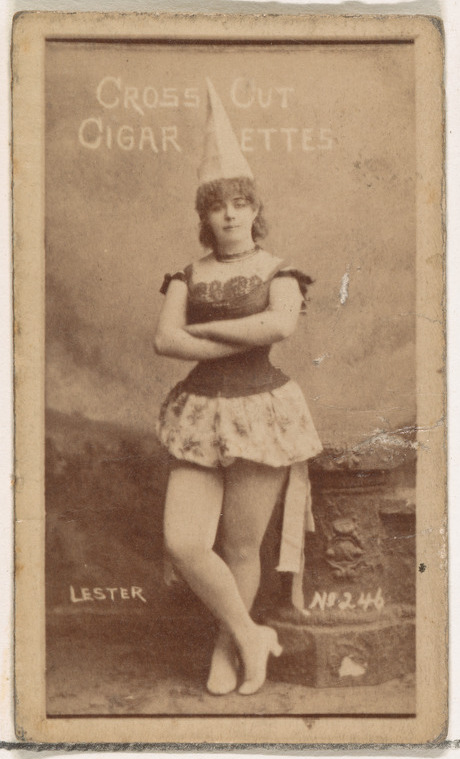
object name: print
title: Card Number 246, Lester, from the Actors and Actresses series (N145-1) issued by Duke Sons & Co. to promote Cross Cut Cigarettes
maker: w. duke, sons & co.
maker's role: publisher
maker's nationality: american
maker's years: 1870-1920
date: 1880-1889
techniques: albumen silver print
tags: portraits,women,actresses